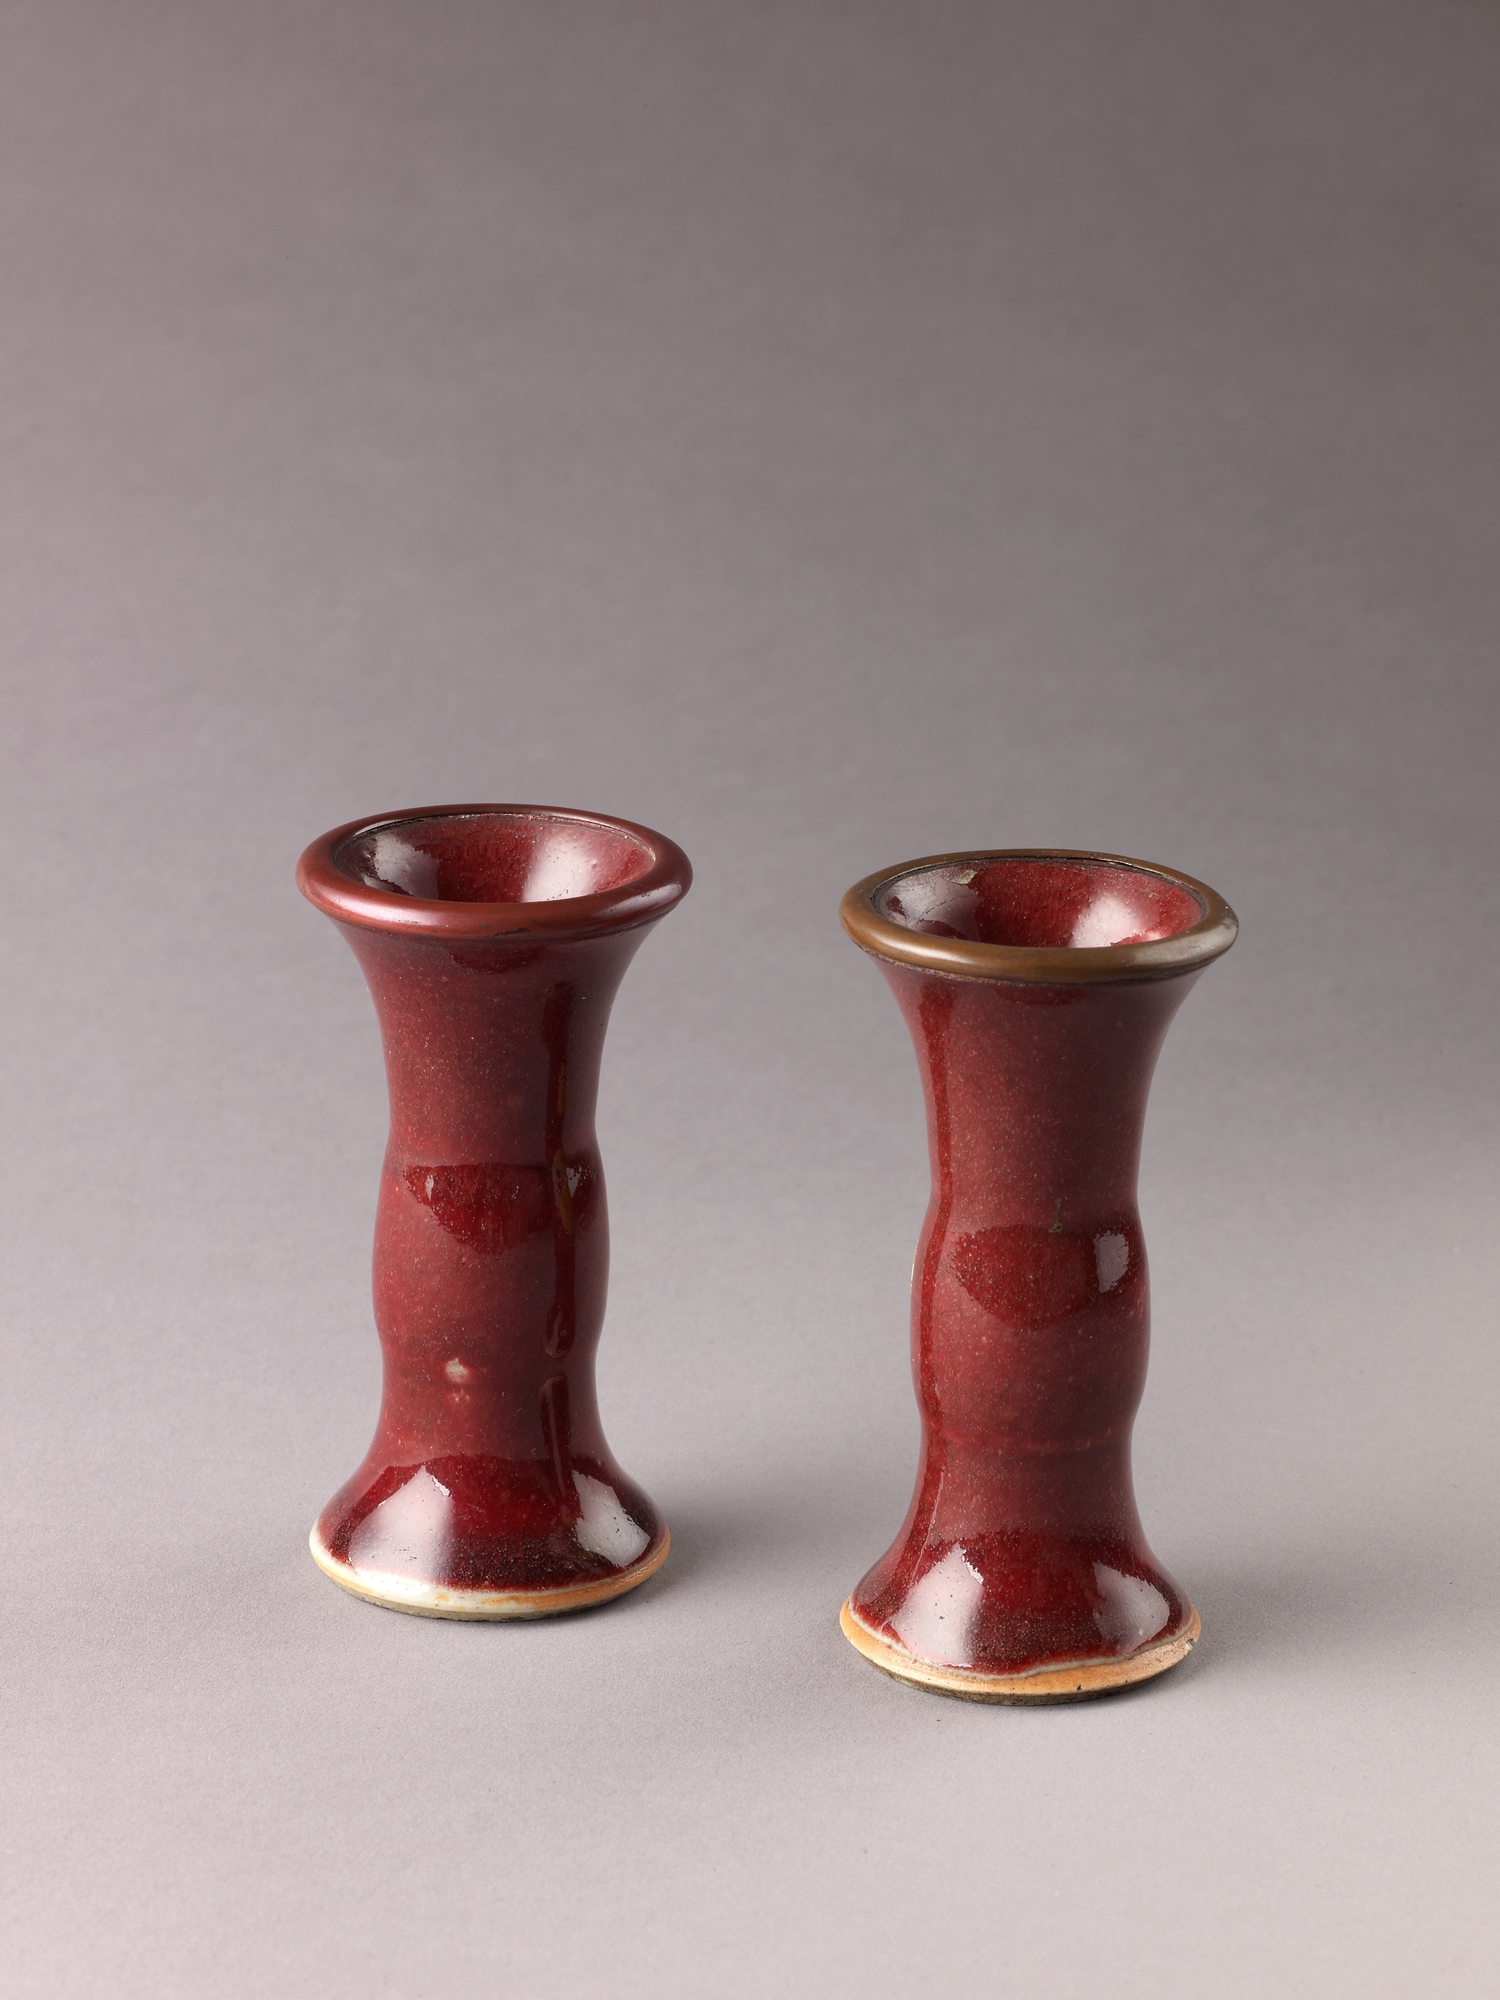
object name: vase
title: Small vase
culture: chinese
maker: chinese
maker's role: artist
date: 1801-1900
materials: glaze, porcelain